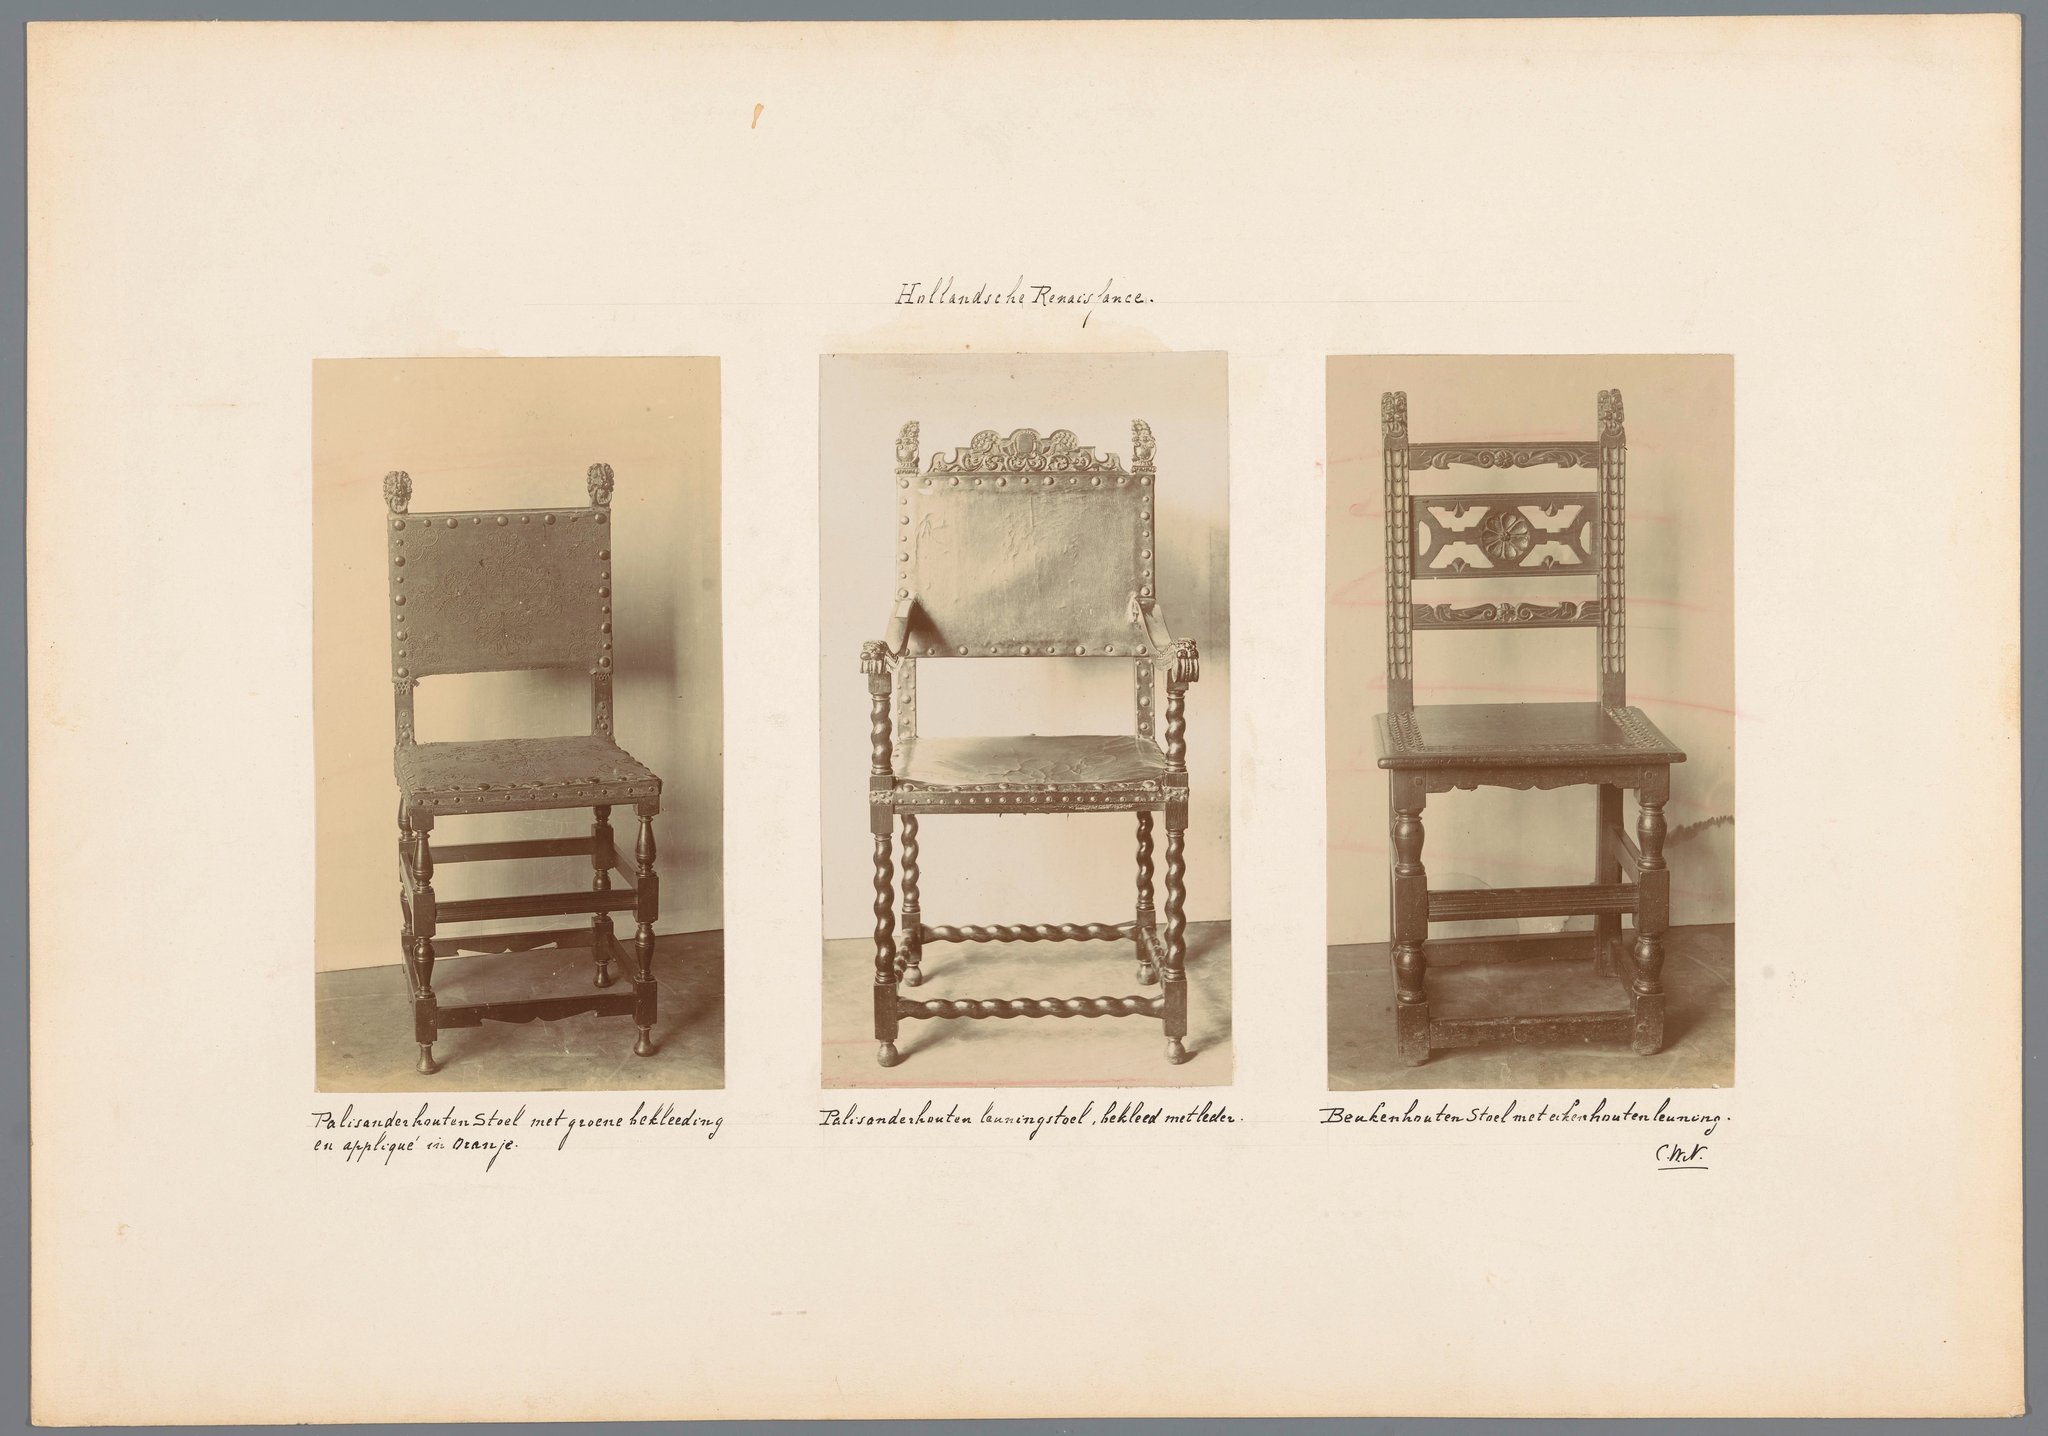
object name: photograph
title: Overzicht van drie houten stoelen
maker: Anonymous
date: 1875-1900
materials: cardboard, photographic support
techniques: daylight paper print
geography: netherlands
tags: chair, beasts of prey, predatory animals: lion, flowers ~ ornament, netherlands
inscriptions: name: ‘C.W.N.’, inscription: ‘Hollandsche Renaissance. Palisanderhouten Stoel met groene bekleeding en appliqué in oranje (...) Beukenhouten stoel met eikenhouten leuning.’, collector's mark: ‘INSTITUUT VOOR KUNST- NIJVERHEIDSONDERWIJS GABRIËL METSUSTRAAT No. 16. AMSTERDAM’, collector's mark: ‘KUNSTNIJVERHEIDSCHOOL QUELLINUS AMSTERDAM FRANS HALSSTRAAT 14.’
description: Links een palissanderhouten stoel met leeuwen, midden een palissanderhouten stoel met armleuningen, rechts een beukenhouten stoel met bloemmotief.